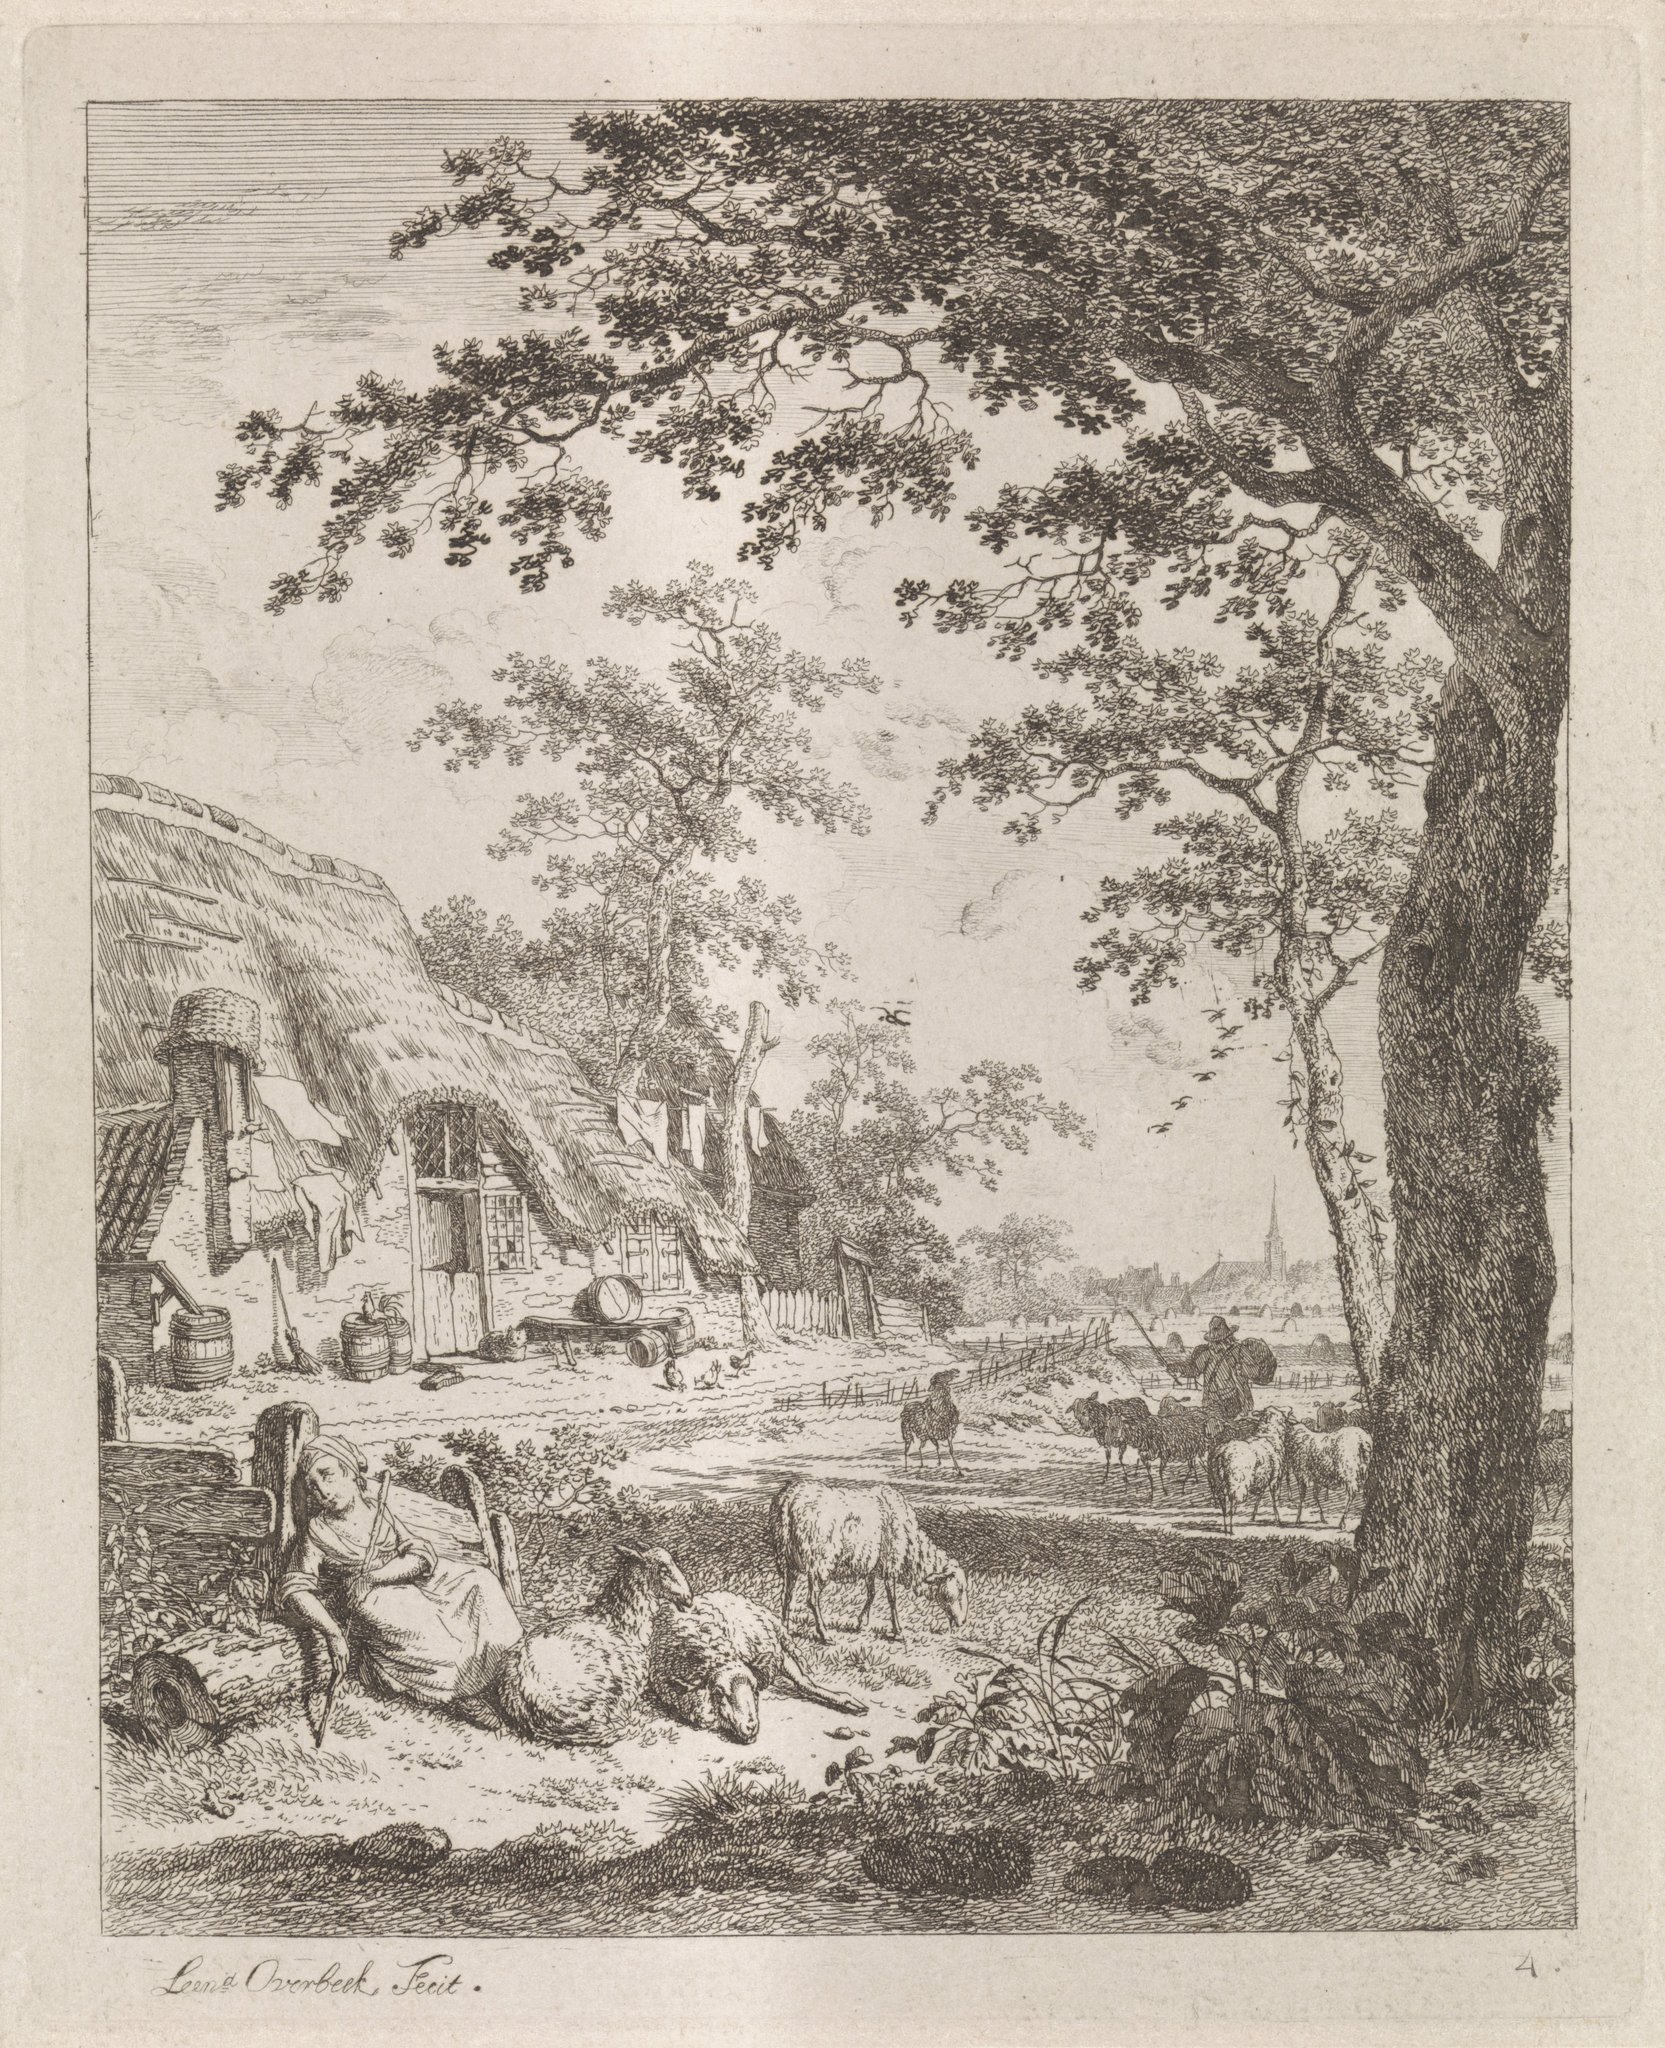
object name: print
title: Landschappen met figuren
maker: leendert overbeek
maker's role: draughtsman, painter, print maker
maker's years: 1752-1815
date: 1791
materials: paper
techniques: etching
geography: haarlem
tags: herding, herdsman, herdswoman, shepherd, shepherdess, cowherd, etc.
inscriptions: collector's mark: Lugt 2228